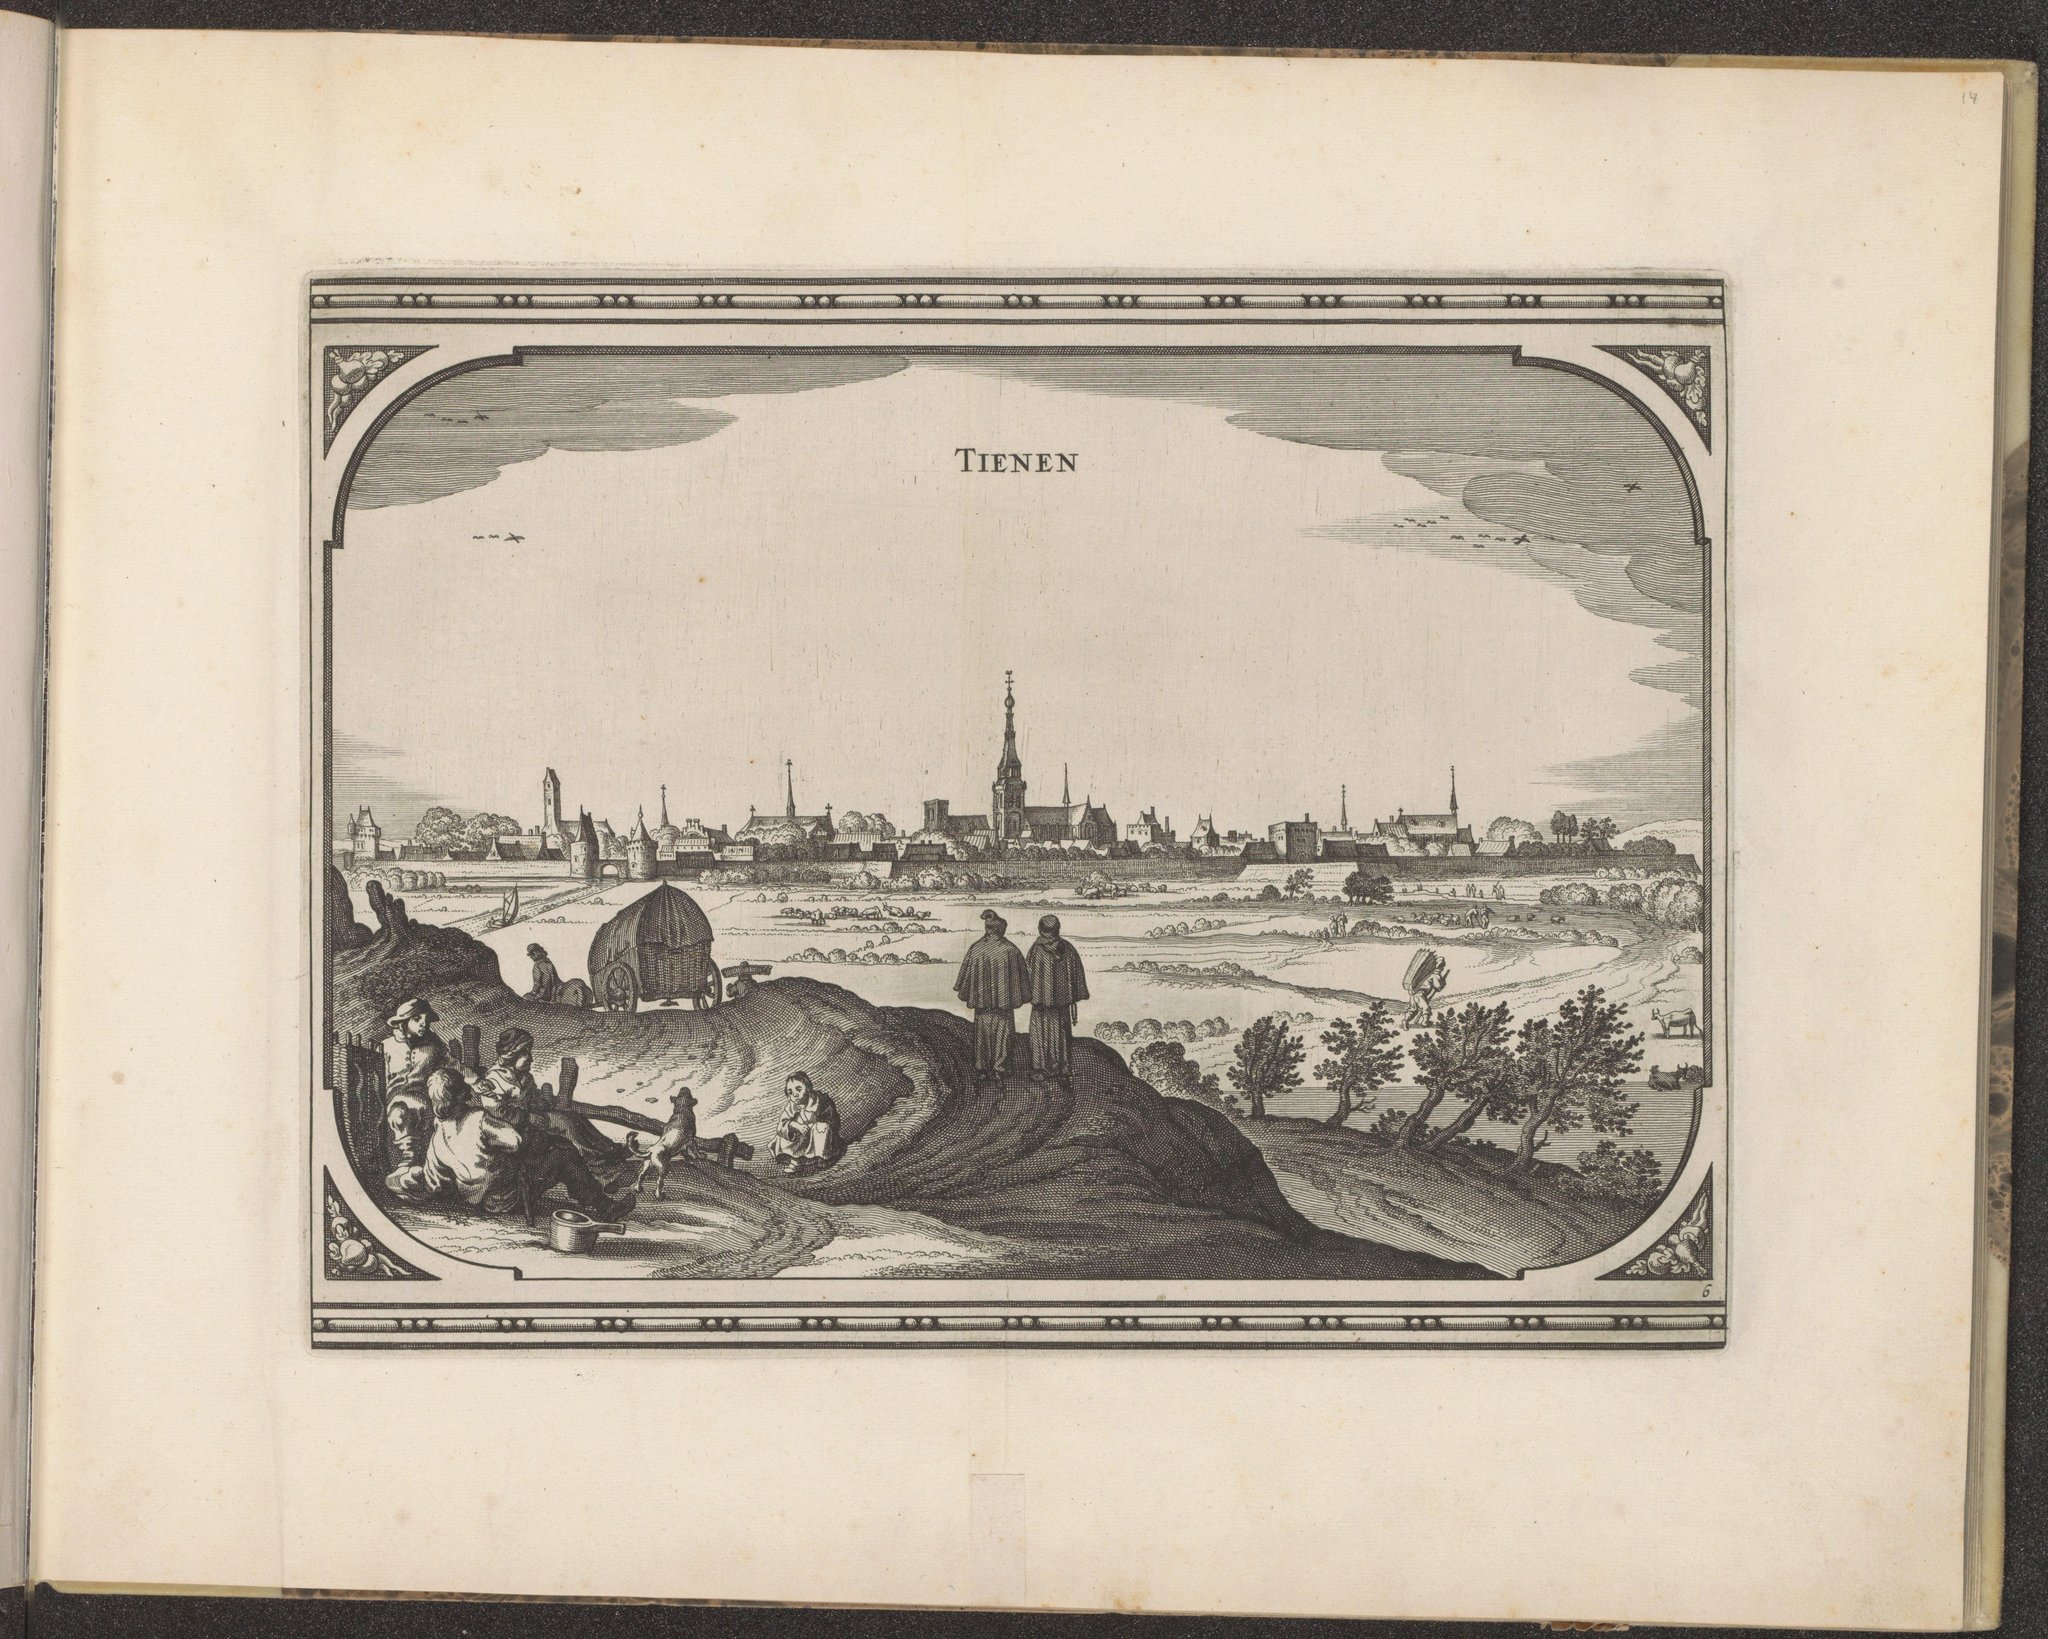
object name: album leaf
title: Gezicht op Tienen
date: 1660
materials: paper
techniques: etching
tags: animal traction, animal-drawn vehicle (carriage etc.), city-view, and landscape with man-made constructions, pedlar, 'en route', traveller under way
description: Gezicht op de stad Tienen. Op de voorgrond zitten drie jongens bij een hek. Verderop kijkt een meisje naar de hond die blaft naar een wegrijdende huifkar. Rechts loopt een marskramer. De prent maakt deel uit van een album.